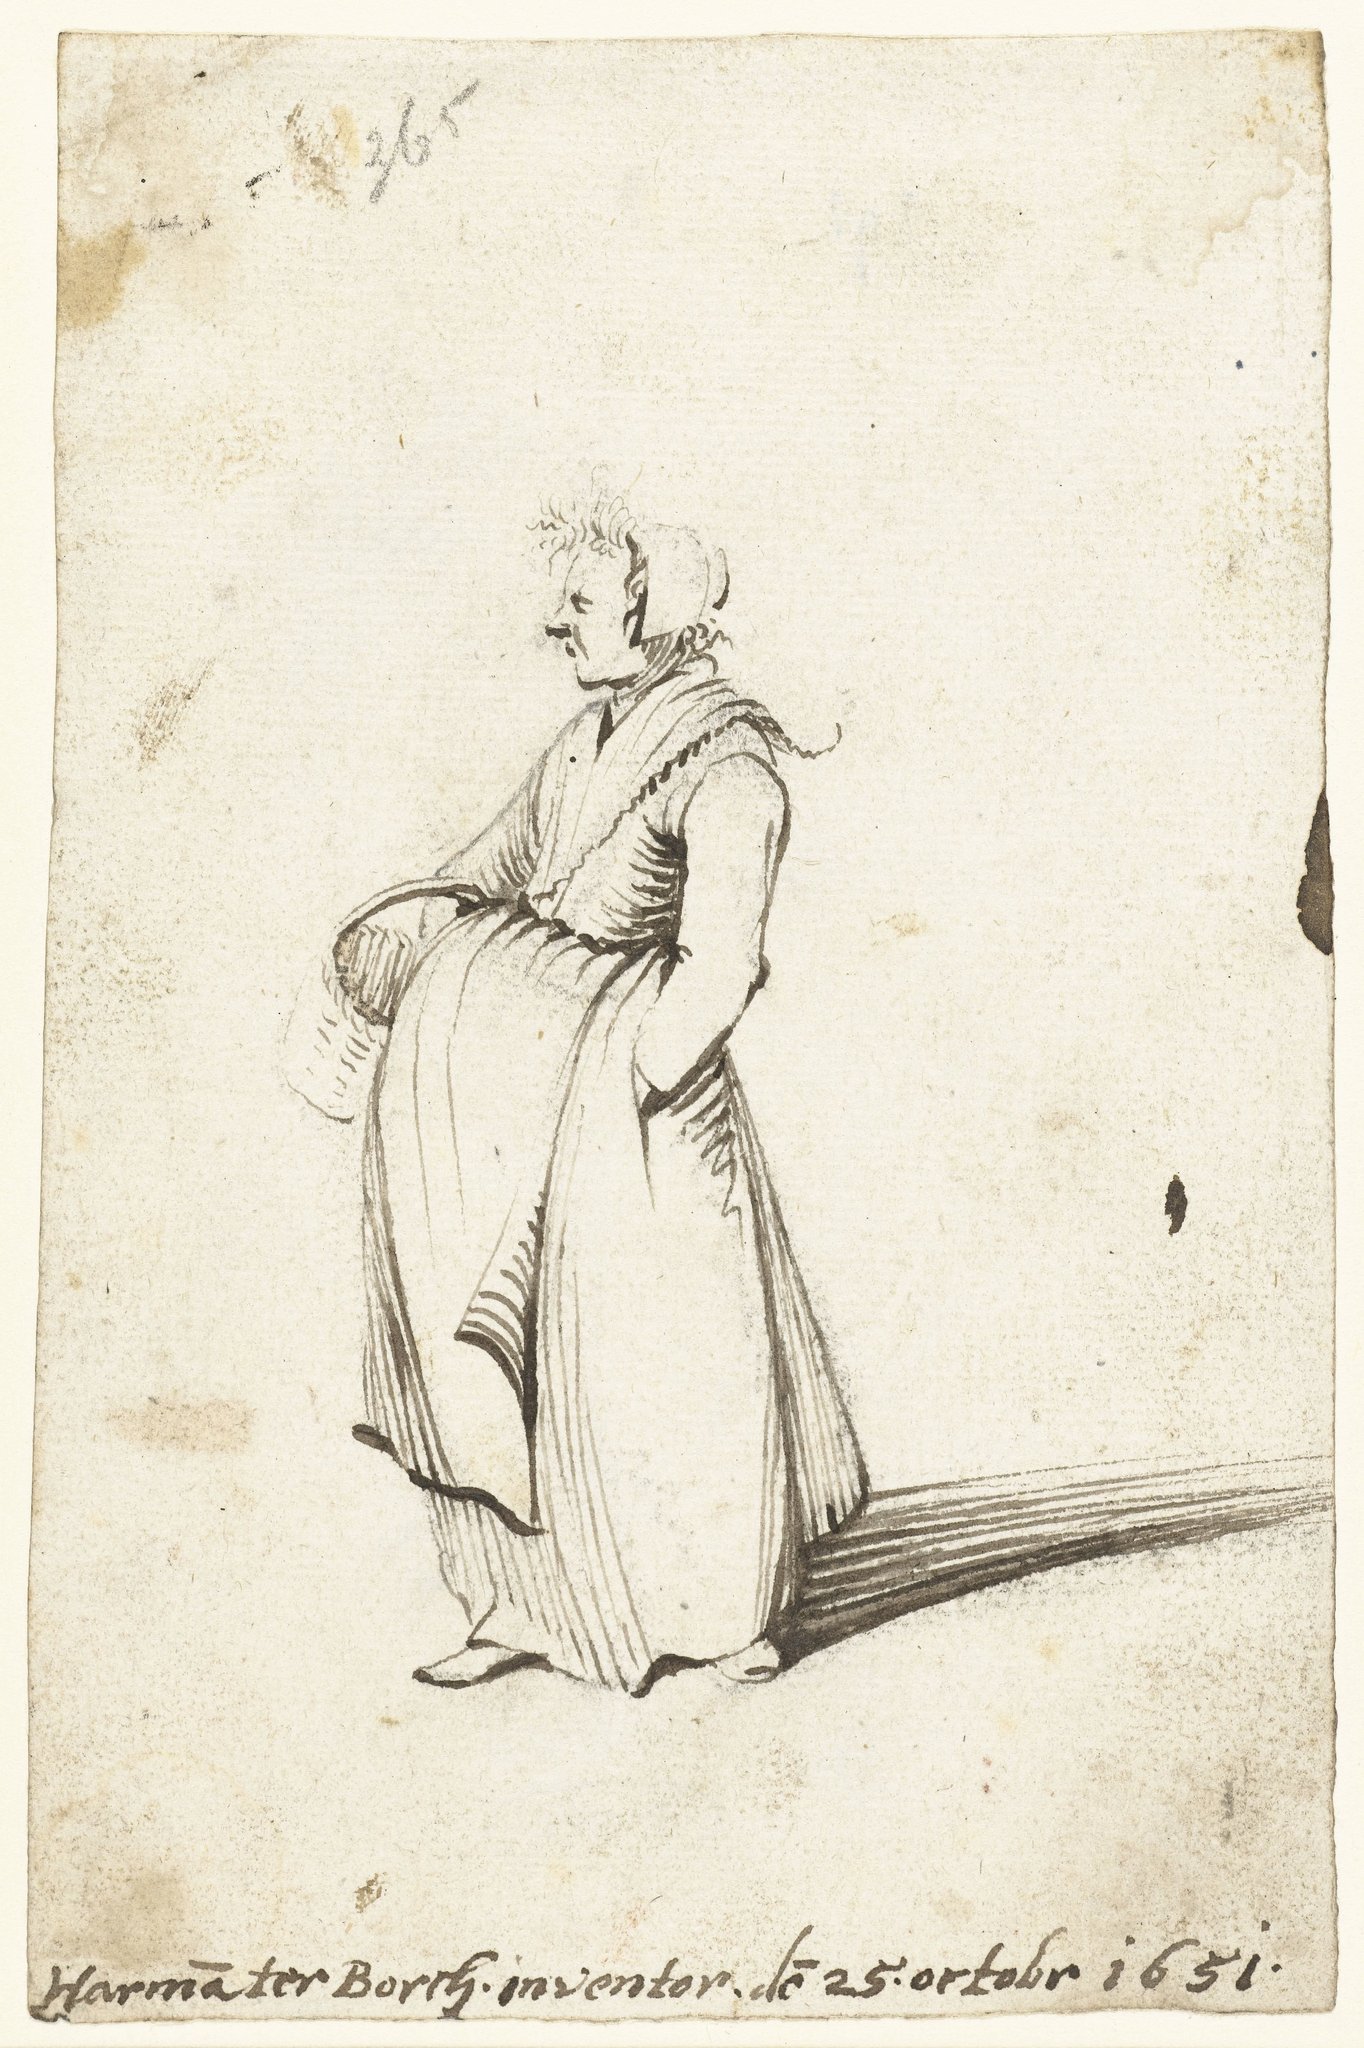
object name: drawing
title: Vrouw met schort om en een mand, naar links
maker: harmen ter borch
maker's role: draughtsman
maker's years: 1638-1677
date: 1651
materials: chalk, ink, paper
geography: zwolle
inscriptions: annotation: ‘Harma[n] ter Borch. inventor de[n] 25 ocobr 1651’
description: Vrouw met schort om en een mand dragend, naar links. Op verso dezelfde vrouw naar rechts (heel licht).